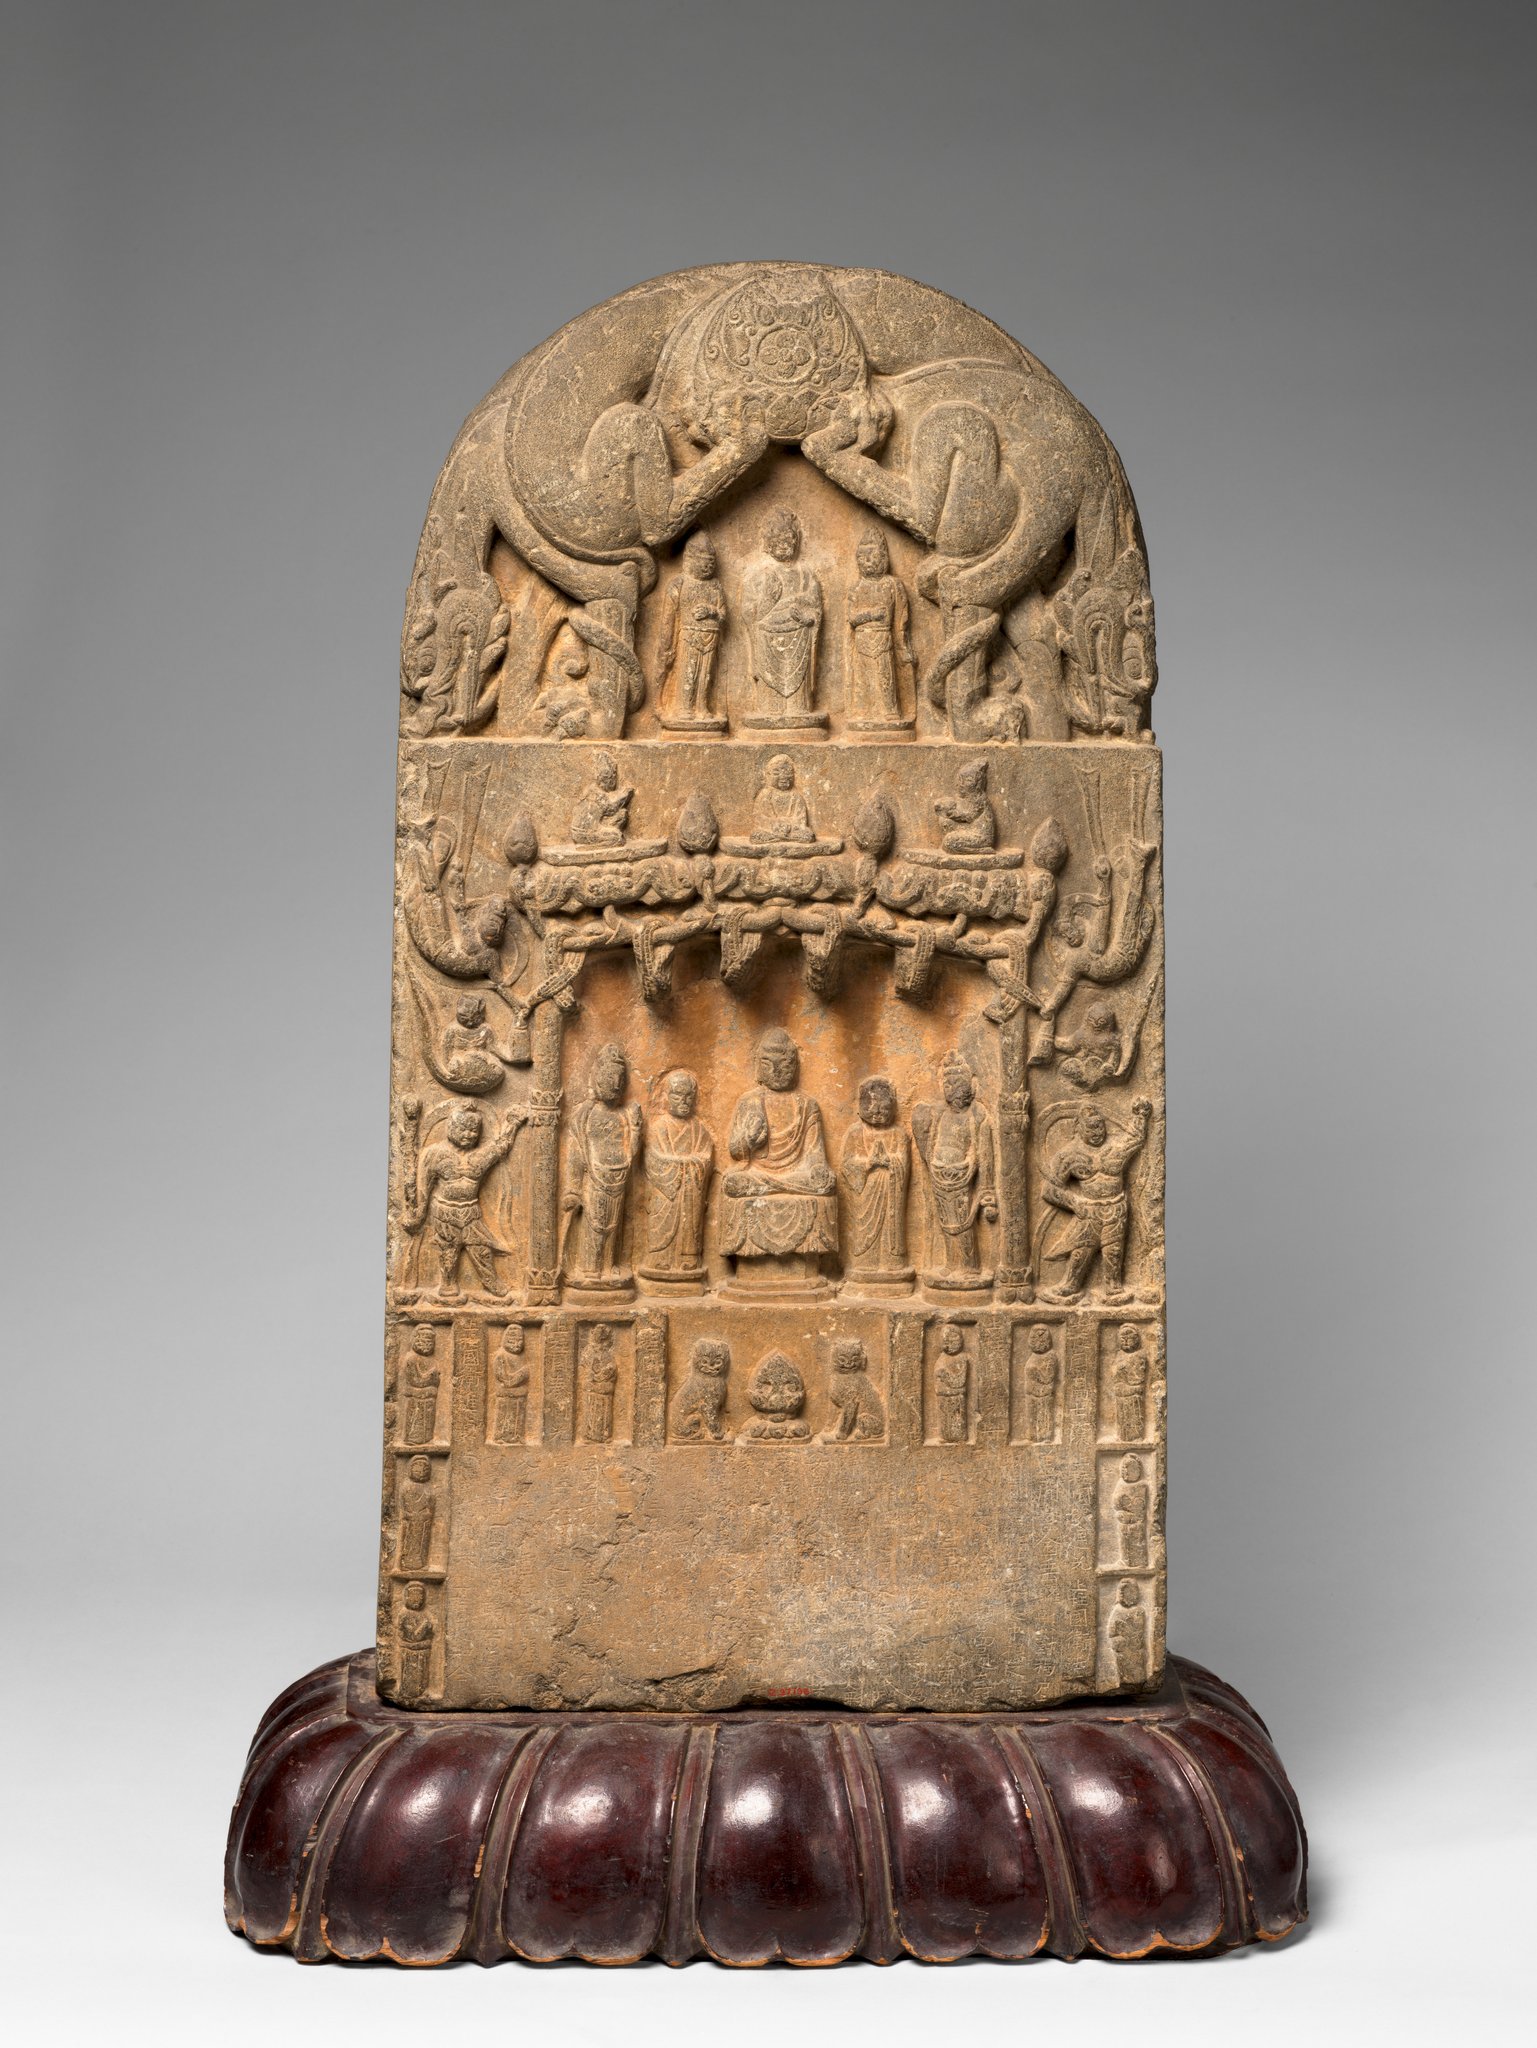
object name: stele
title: Stele with Pure Land Imagery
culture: chinese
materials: limestone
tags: animals,buddha